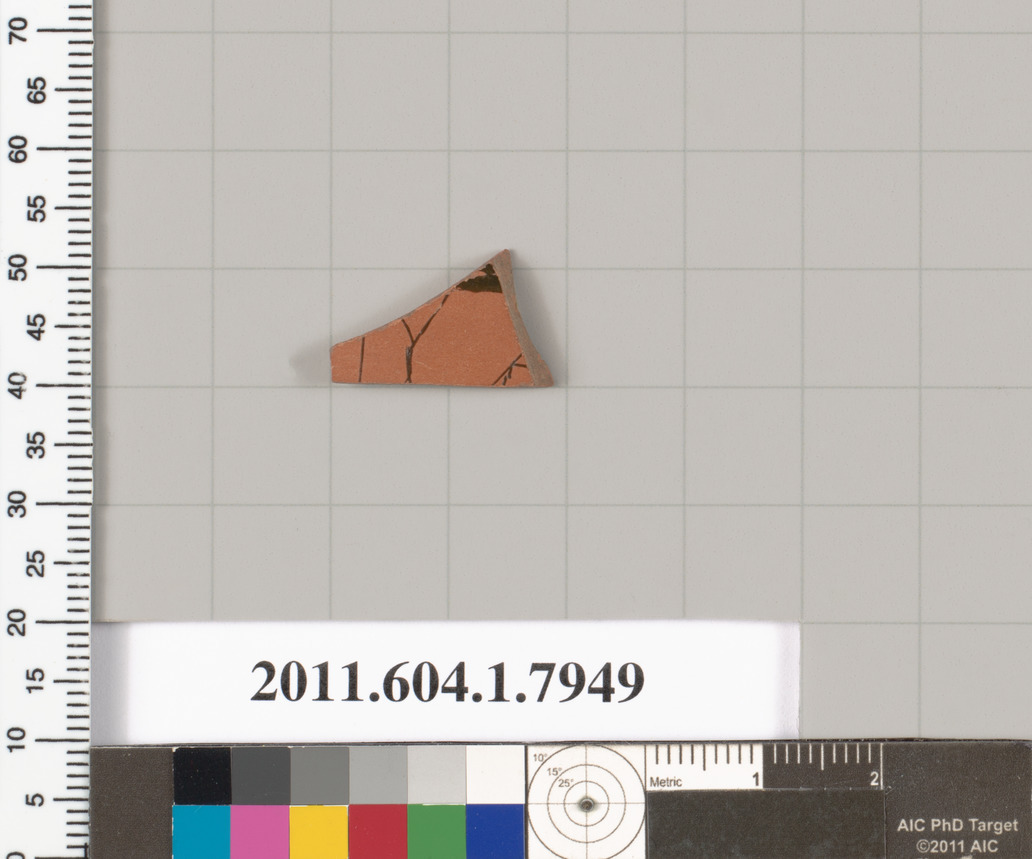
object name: kylix fragment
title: Terracotta fragment of a kylix (drinking cup)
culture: greek, attic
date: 460-450 BCE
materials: terracotta